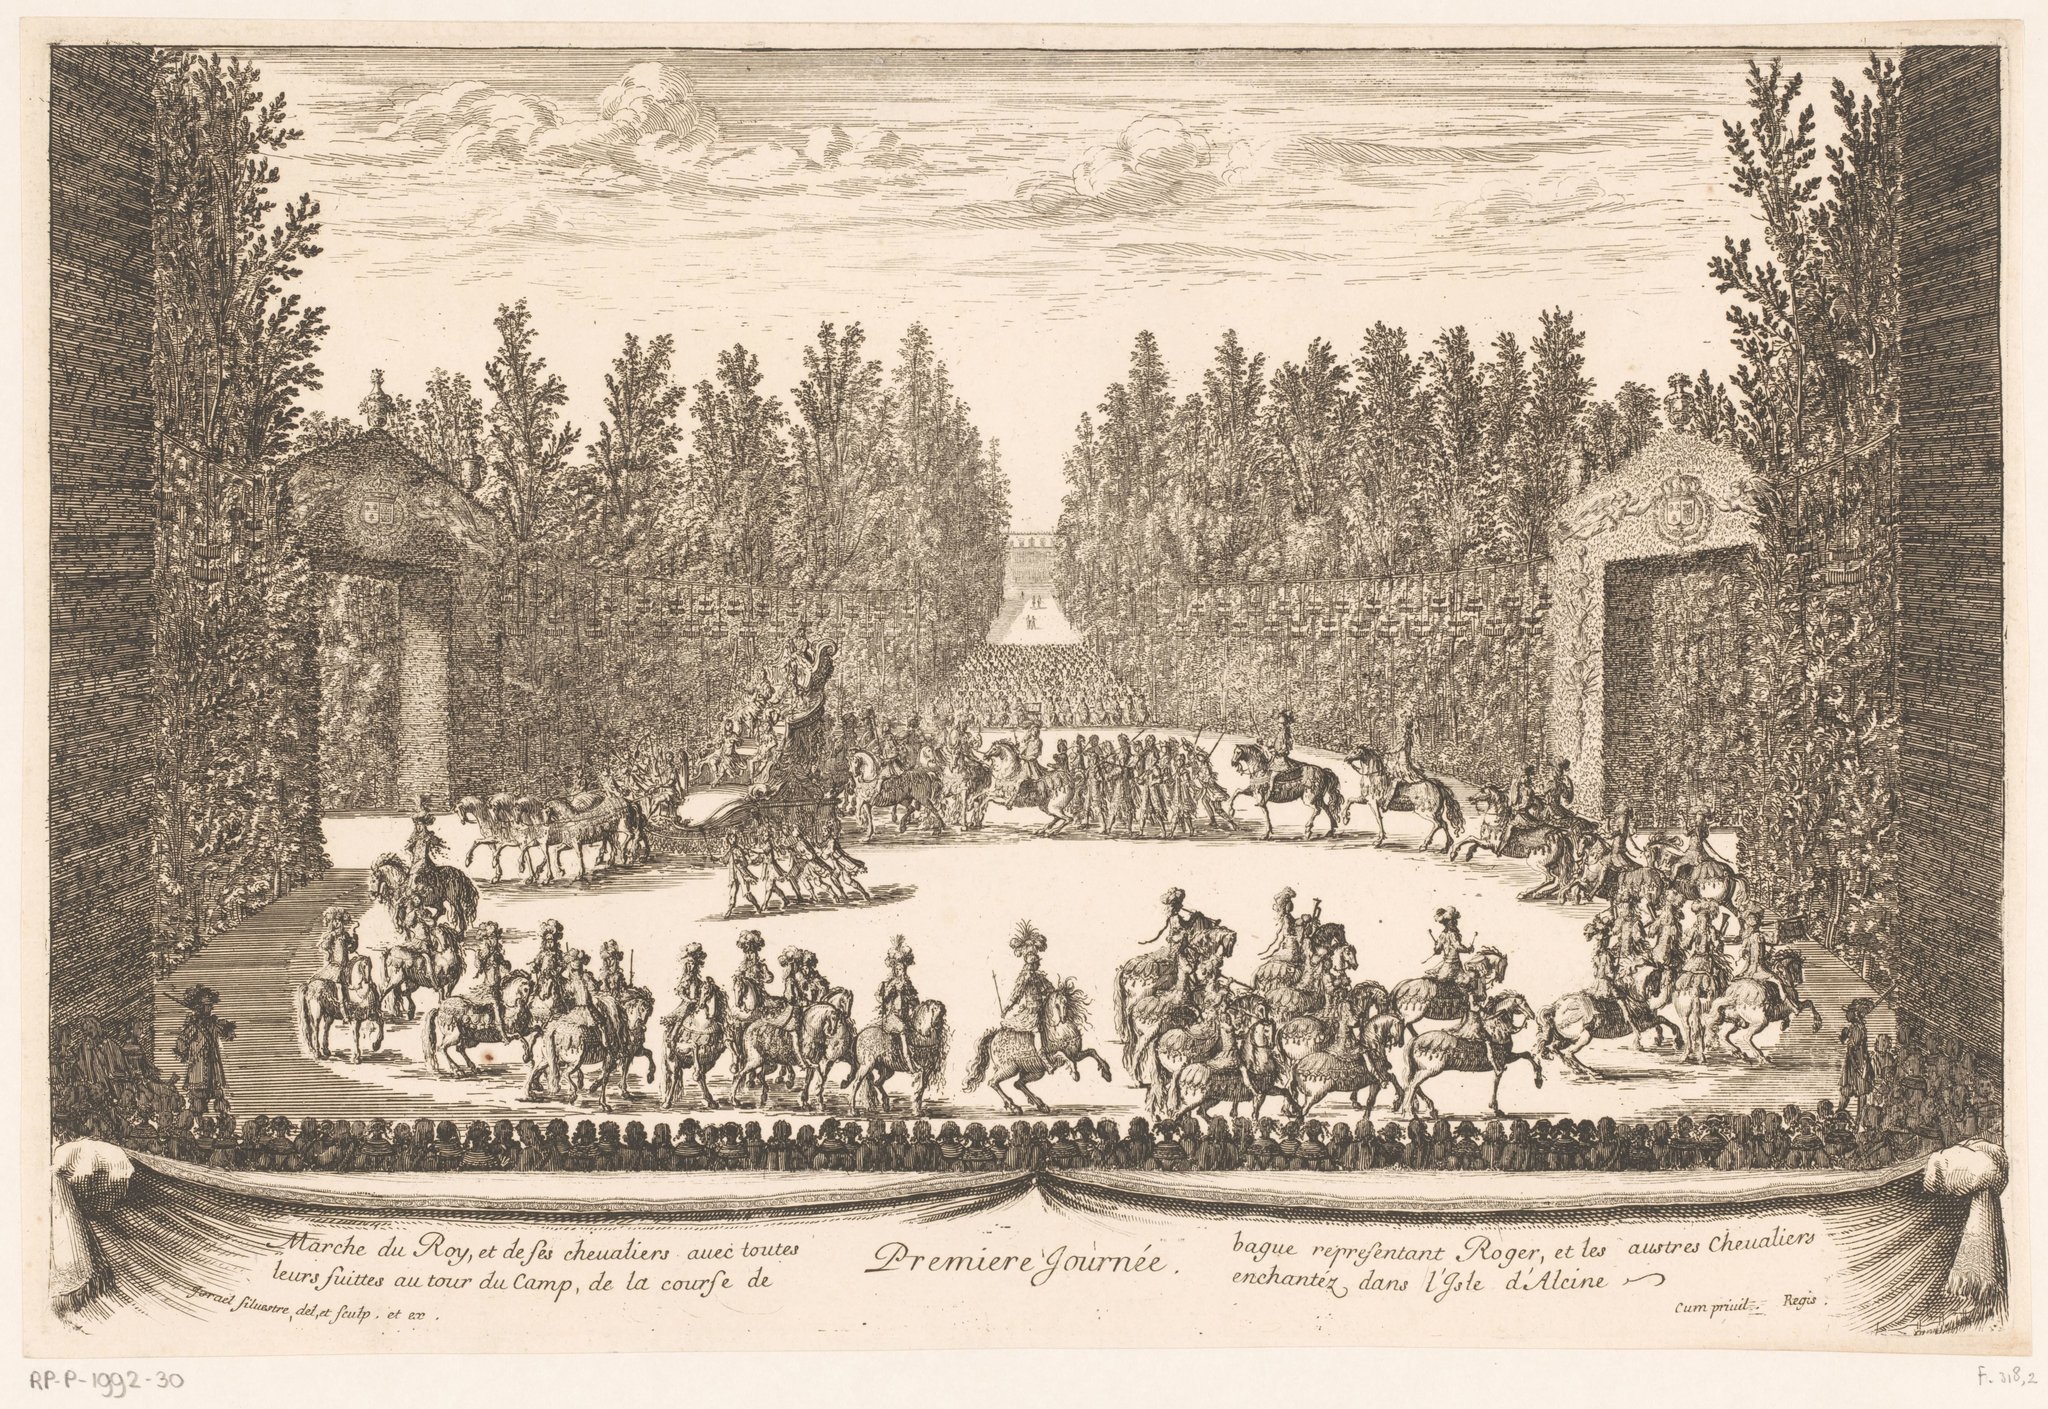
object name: print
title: Feesten op Versailles in 1664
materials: paper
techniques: engraving, etching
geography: france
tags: lodewijk xiv (koning van frankrijk), performance, walking (horse in motion), french or architectonic garden; formal garden, festivities, king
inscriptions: collector's mark: Lugt 2760, collector's mark: Lugt 2228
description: 'Les plaisirs de l'Isle enchantée, ou les festes, et diverstissements du Roy, à Versailles [...]' is een serie van negen prenten met de feesten die Lodewijk XIV in 1664 in Versailles organiseerde ter ere van zijn moeder Anna van Oostenrijk en zijn echtgenote Maria-Theresia.